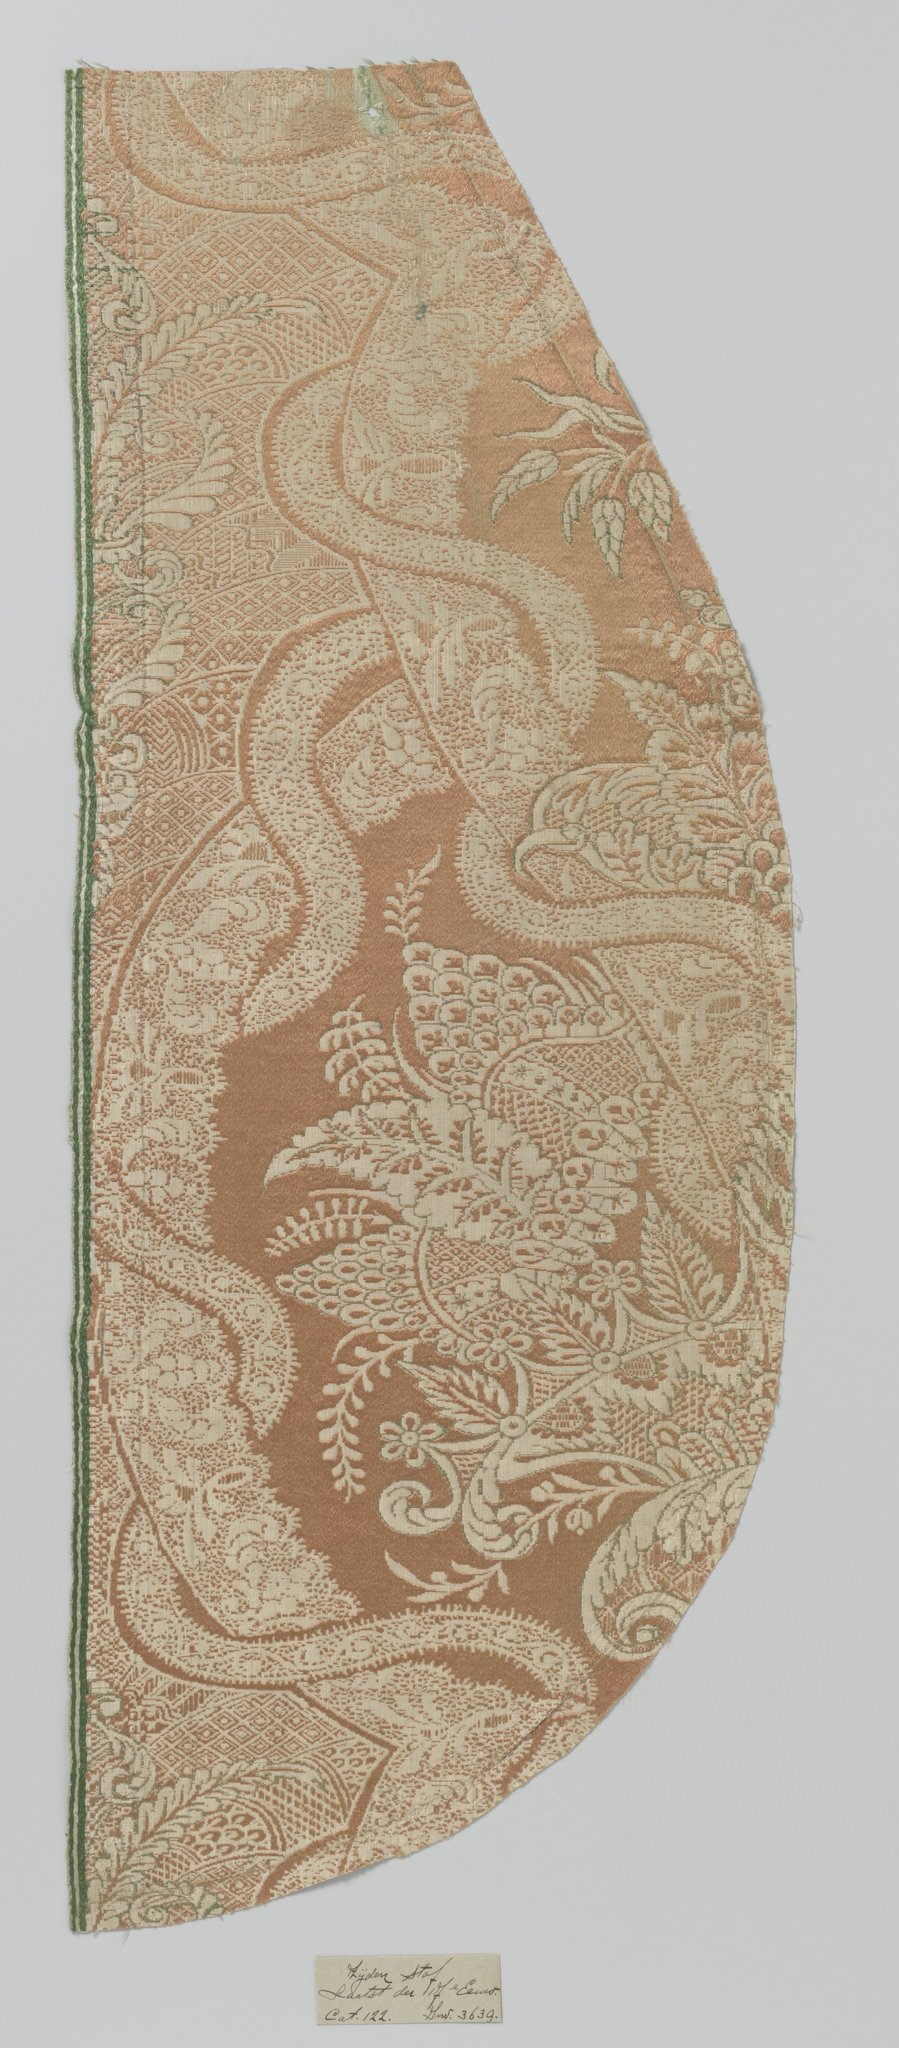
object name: fragment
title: Fragment zijdelampas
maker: Anonymous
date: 1720-1730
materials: silk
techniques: lampas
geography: italy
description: Fragment zijdelampas, min of meer halfrond, met kantpatroon en bloem- en bladwerk.